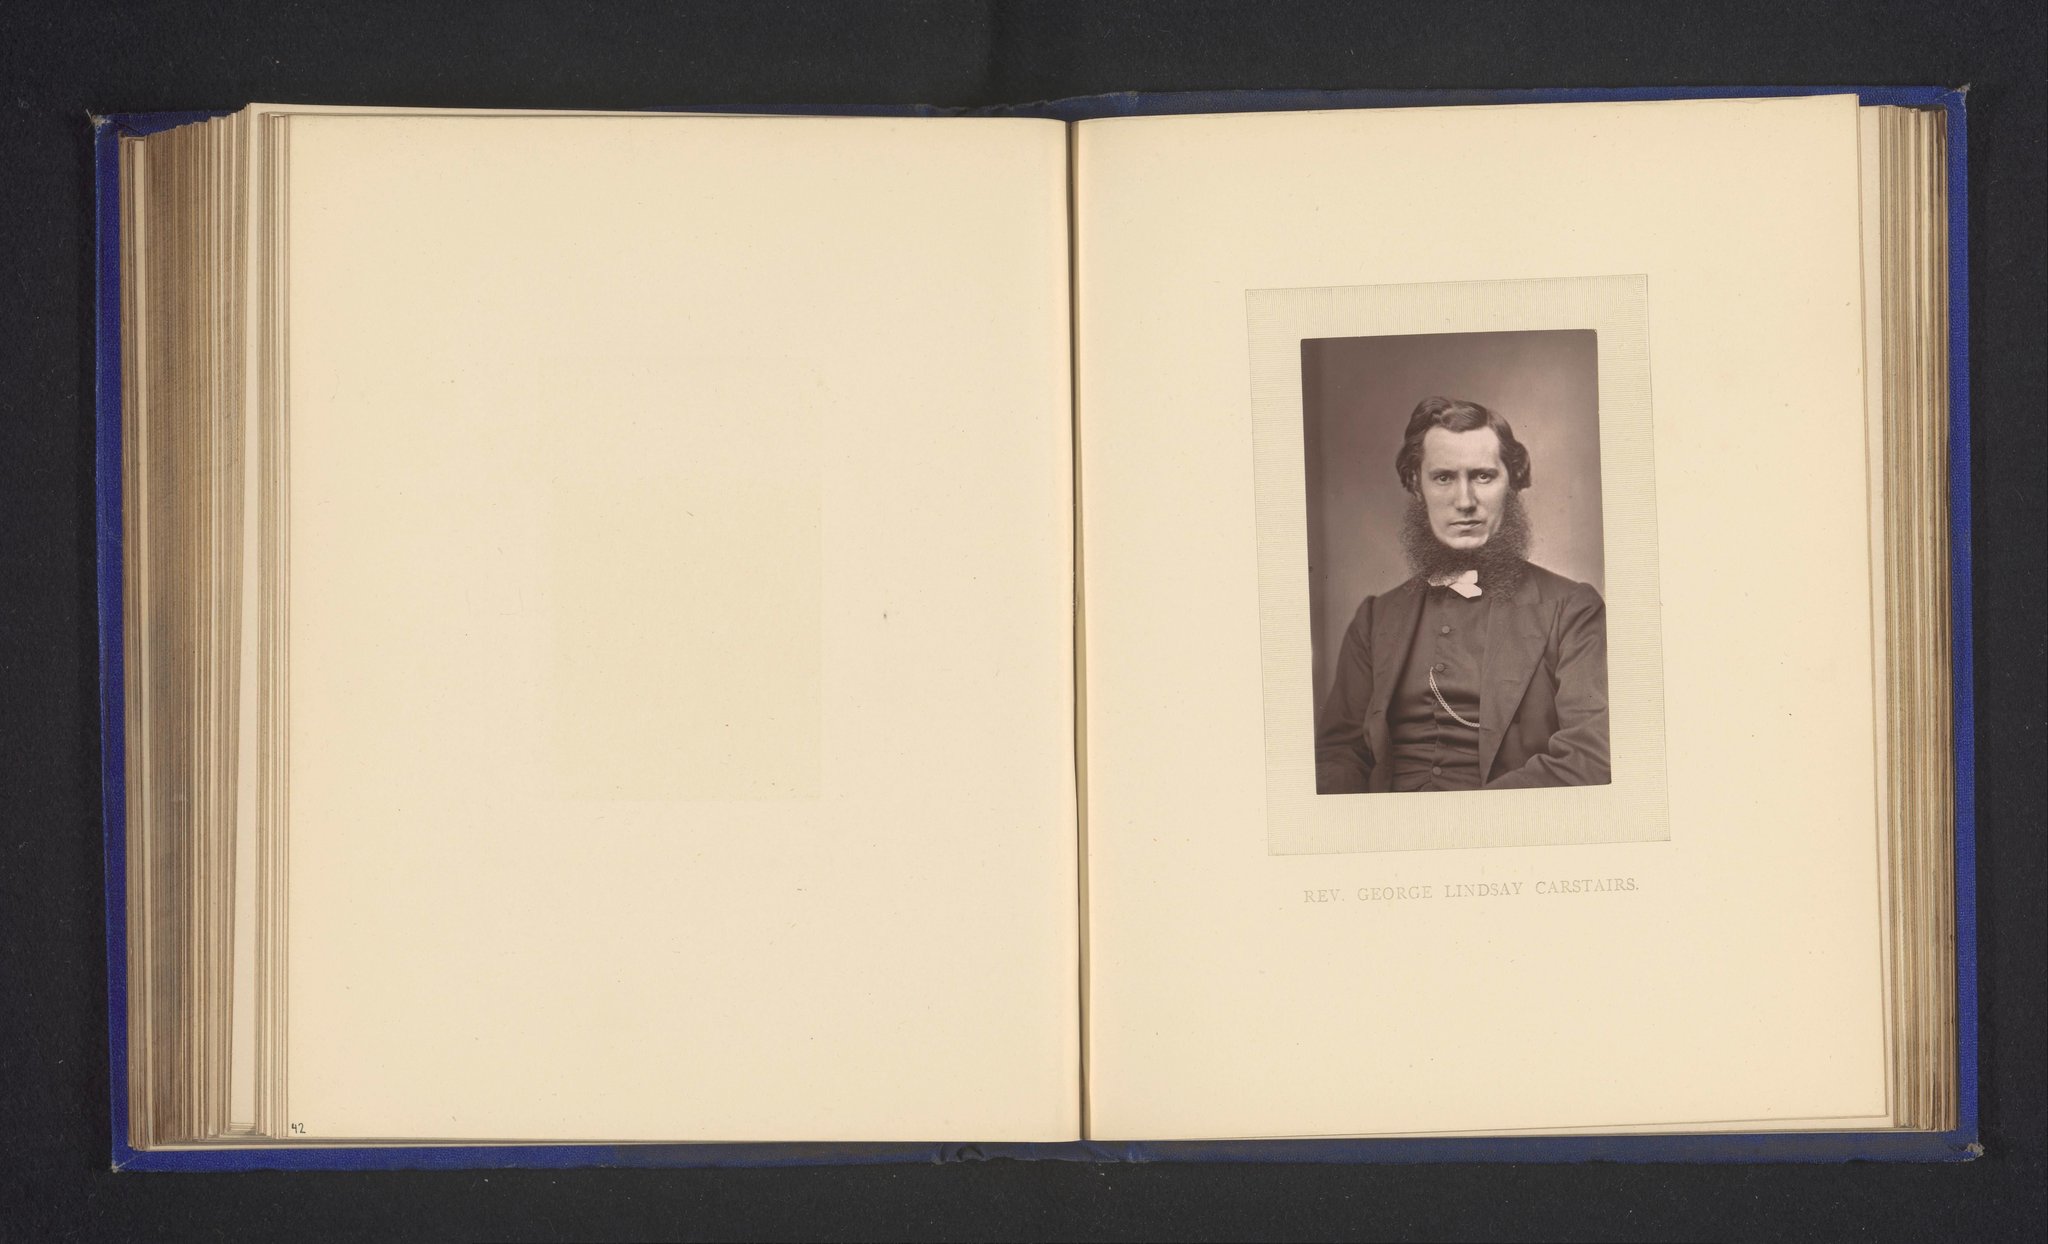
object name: page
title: Portret van George Lindsay Carstairs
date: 1865-1875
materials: paper, photographic support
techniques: carbon print, woodburytype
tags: functionaries and dignitaries (with name) ~ protestant churches